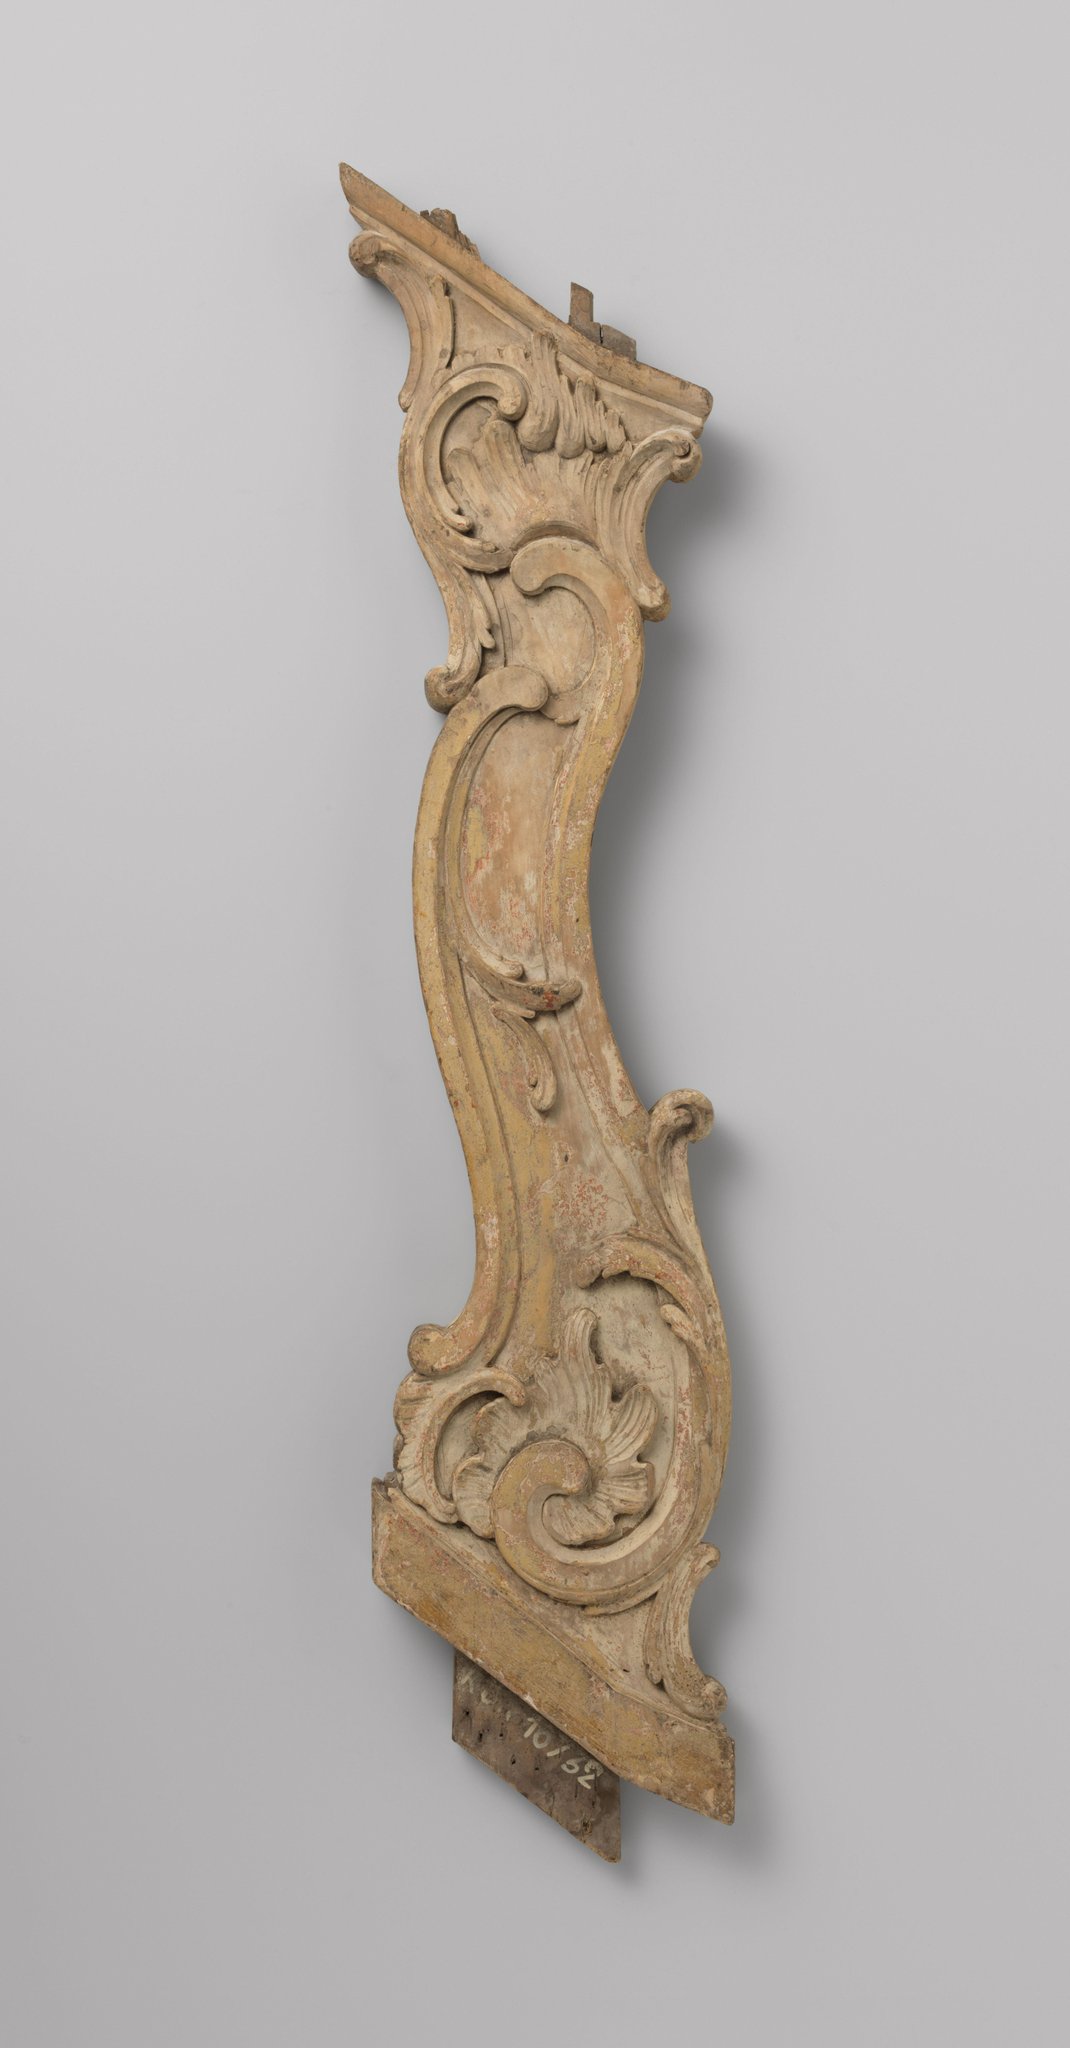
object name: trapbaluster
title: Baluster met gestoken C- en S-voluten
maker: Anonymous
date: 1740-1760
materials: wood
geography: northern netherlands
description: S-vormige baluster met gestoken C- en S-voluten met rocaille-schelpen.